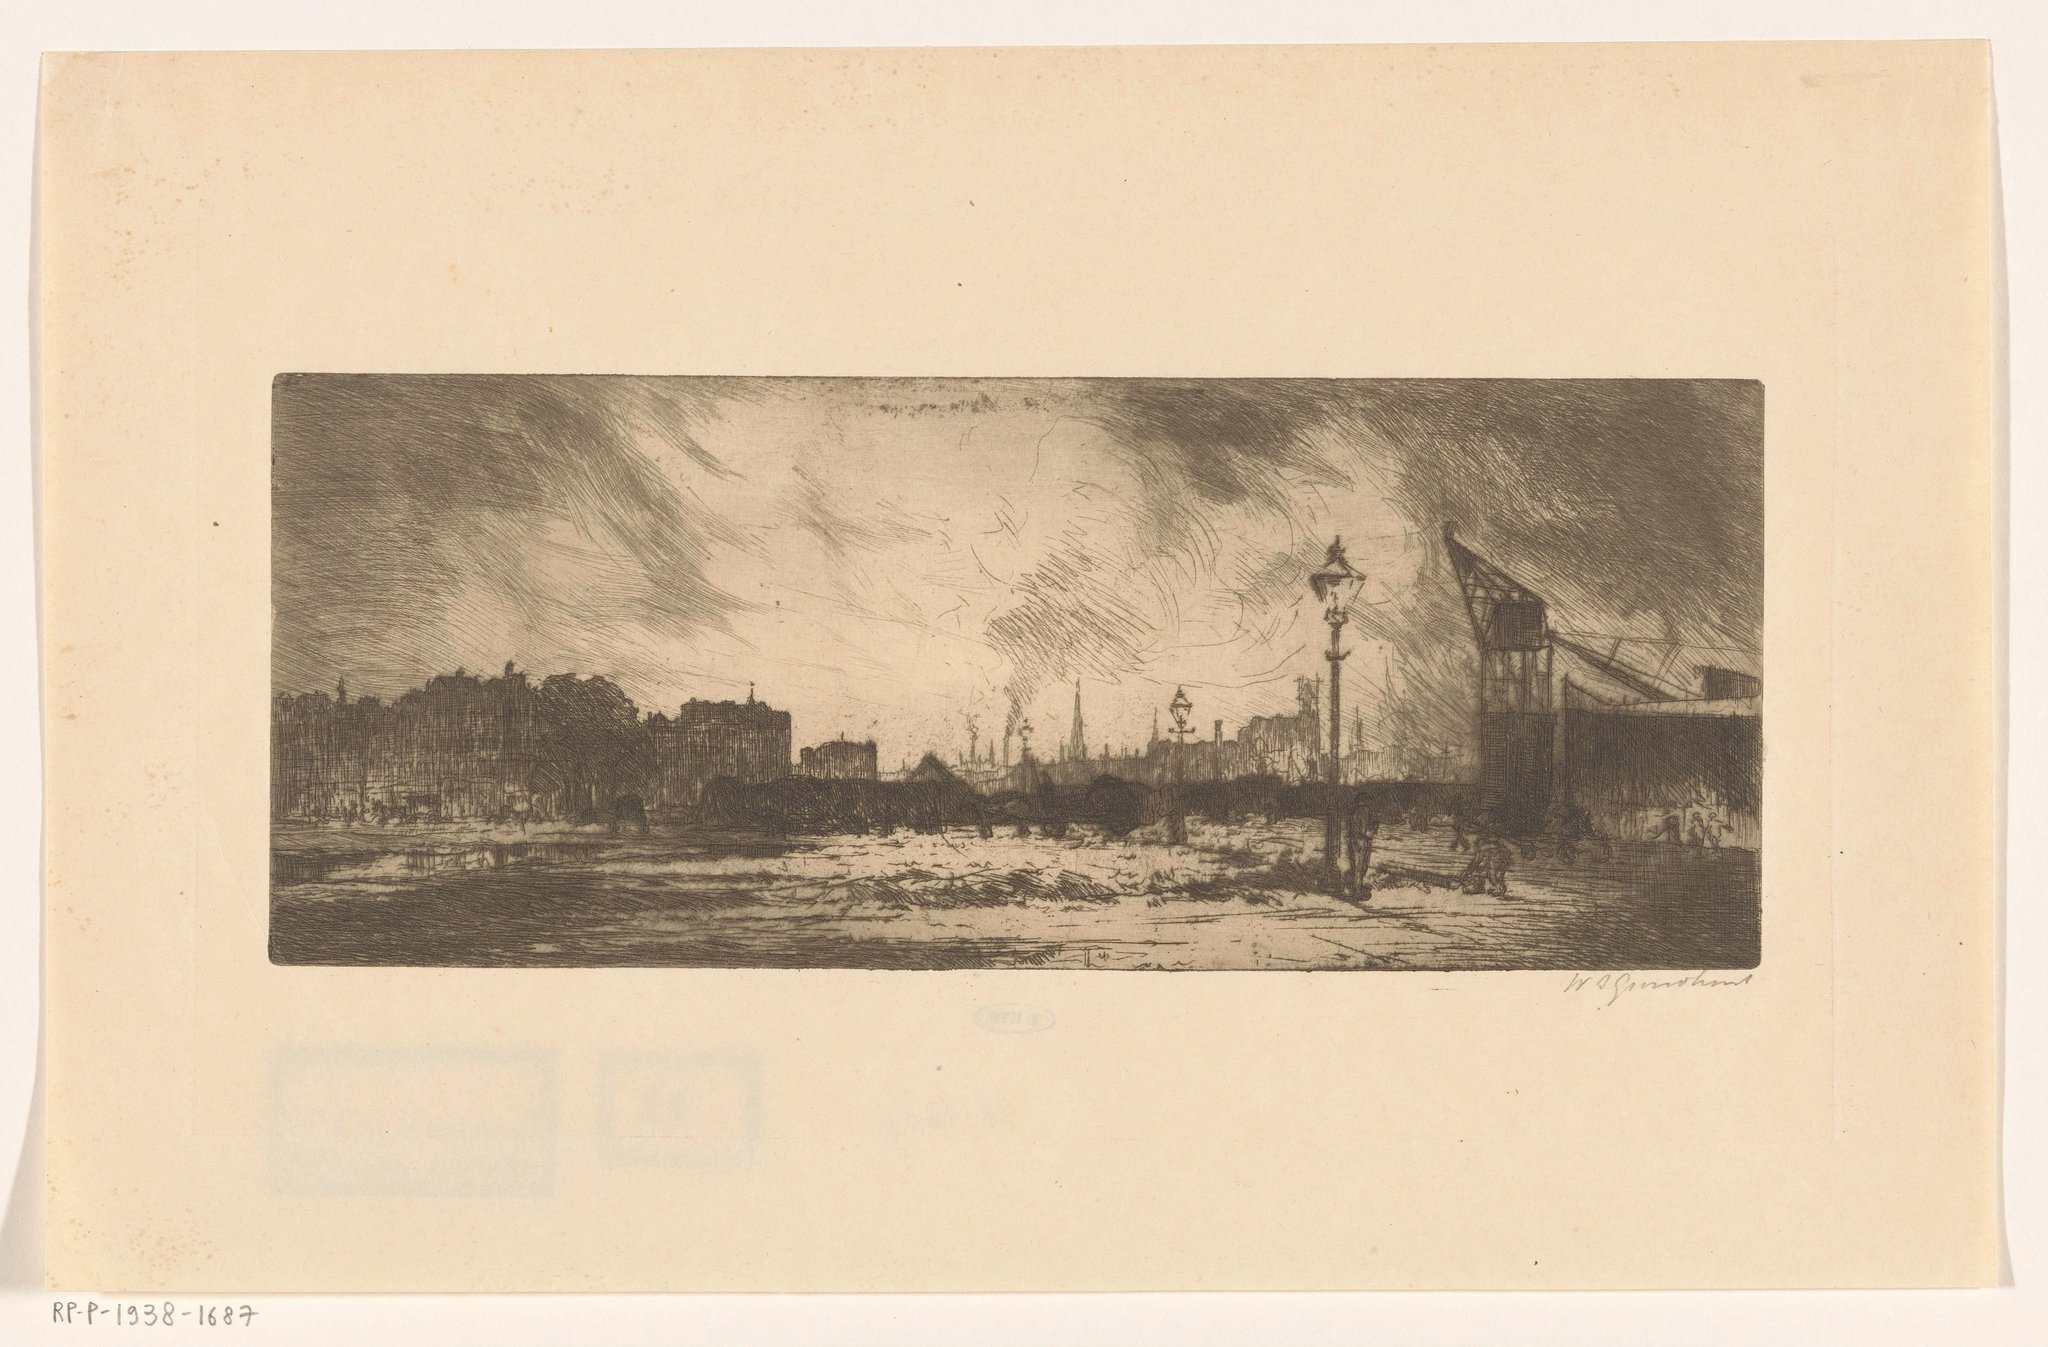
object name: print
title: Havenkade met lantaarnpalen in Rotterdam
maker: willem adrianus grondhout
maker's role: draughtsman, painter, print maker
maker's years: 1878-1934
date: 1888-1934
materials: paper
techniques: etching, intaglio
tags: harbour, street lighting, rotterdam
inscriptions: collector's mark: Lugt 2228